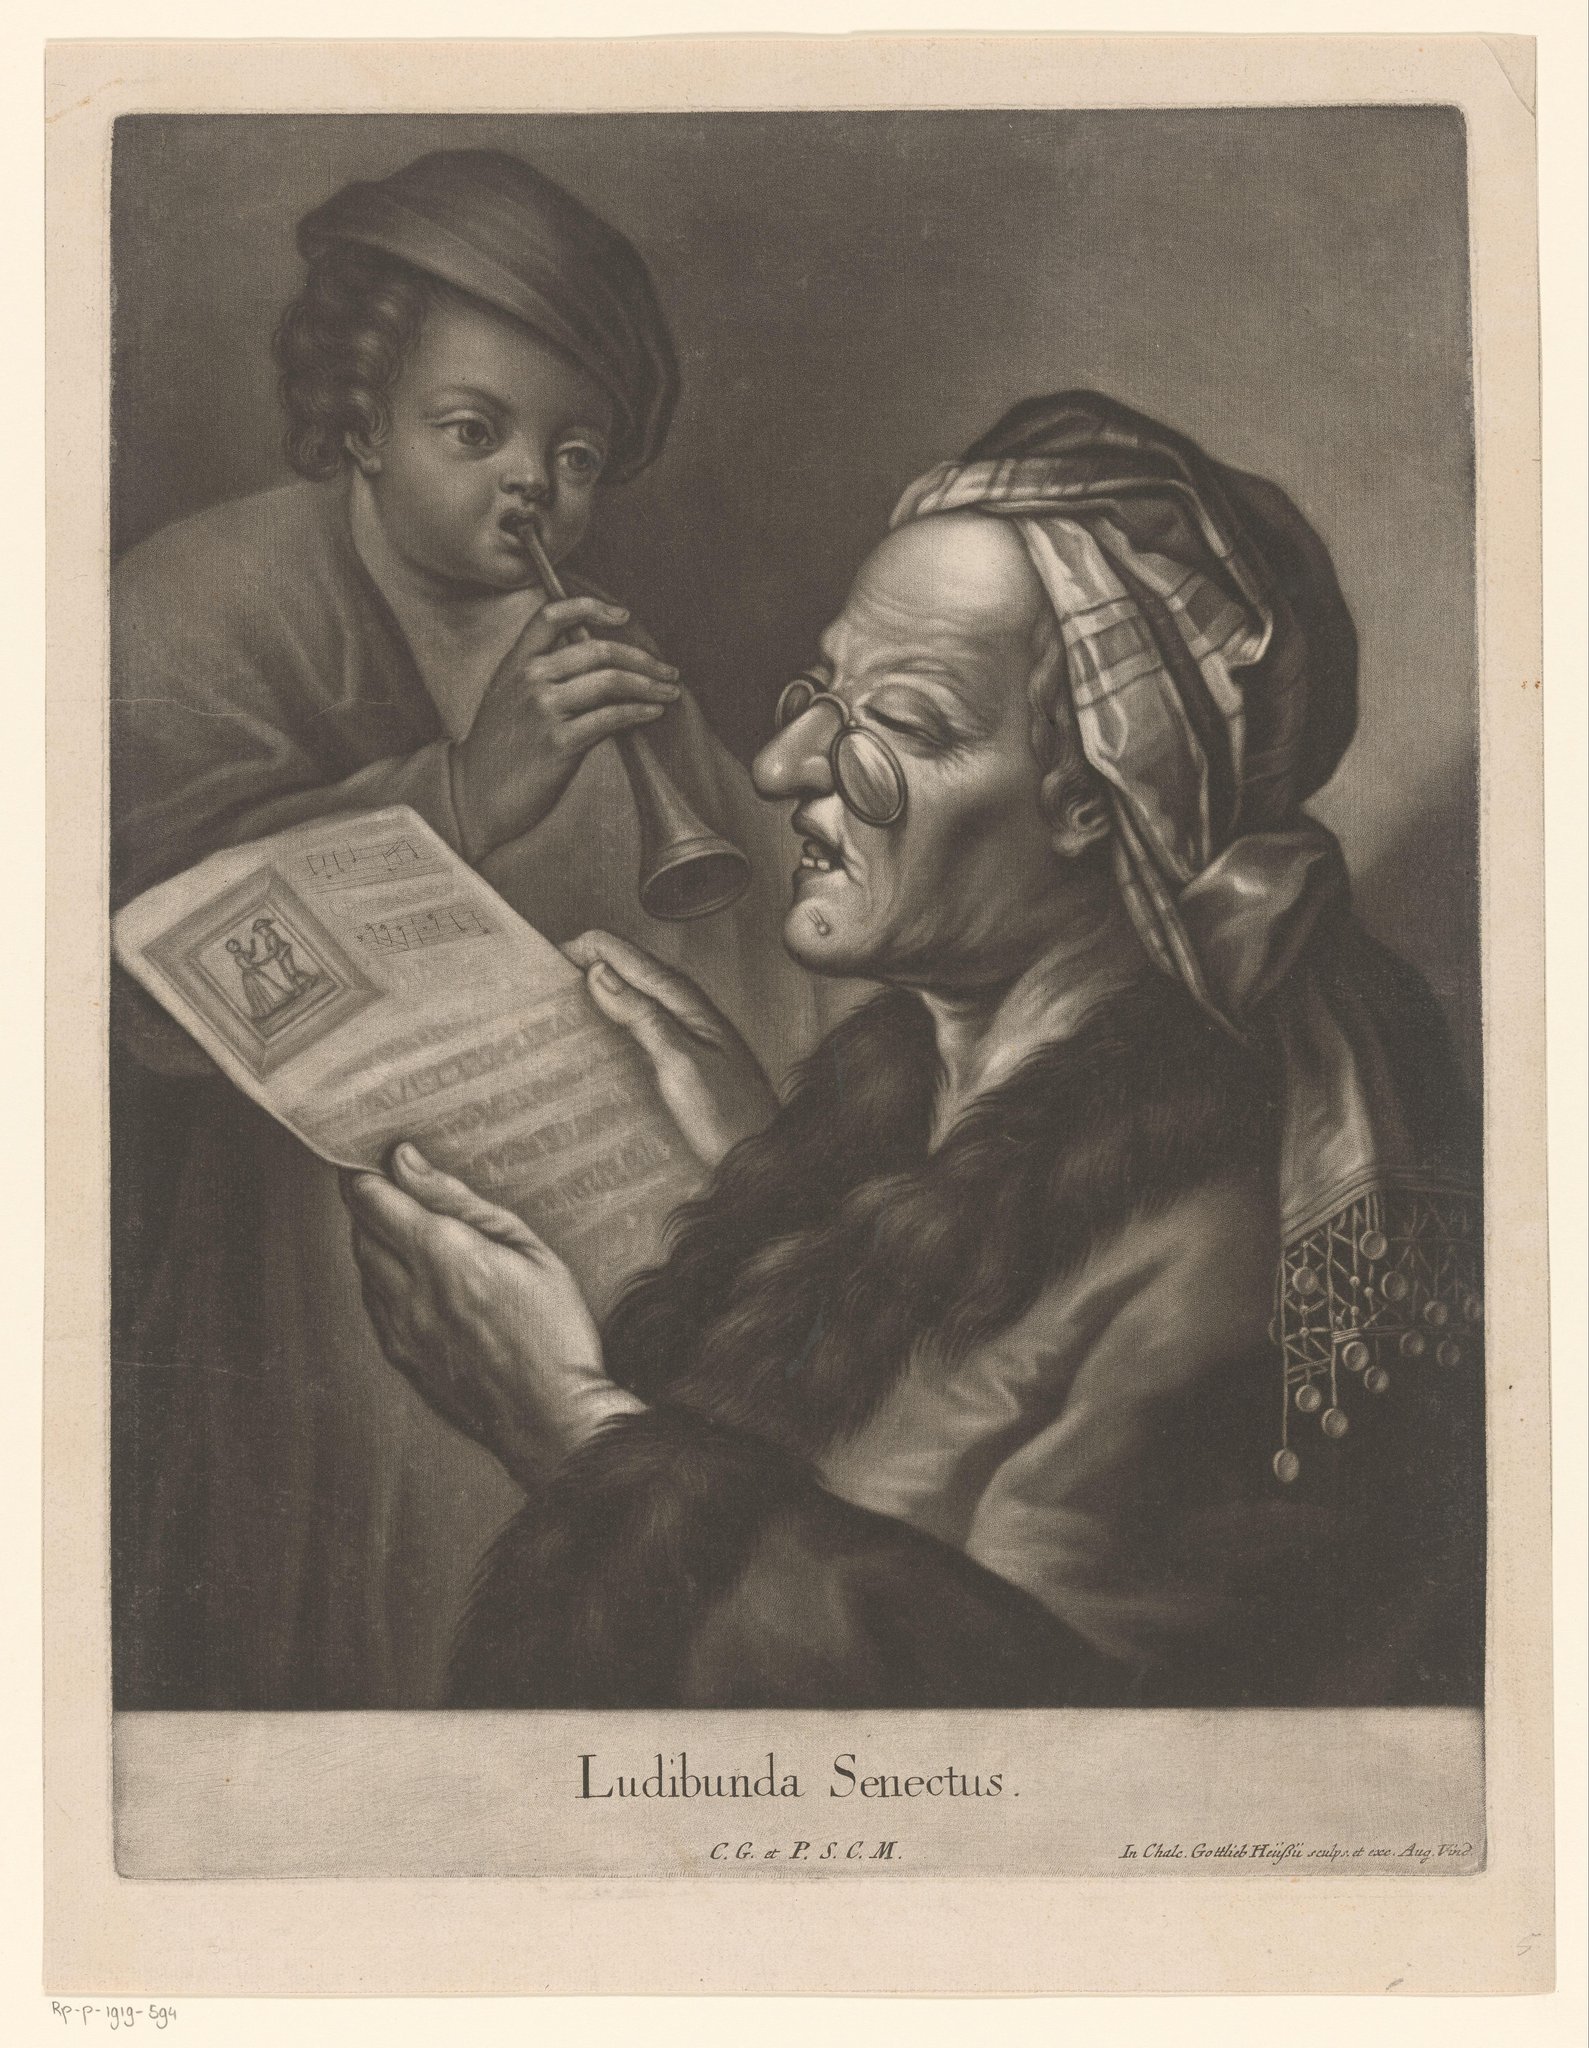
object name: print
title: Zingende oude vrouw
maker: gottlieb heiss (ii)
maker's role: print maker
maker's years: 1723-1775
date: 1733-1775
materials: paper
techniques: etching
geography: germany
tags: notation of music, horn, trumpet, cornet, trombone, tuba, old woman, vocal music, singing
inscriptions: collector's mark: Lugt 2233